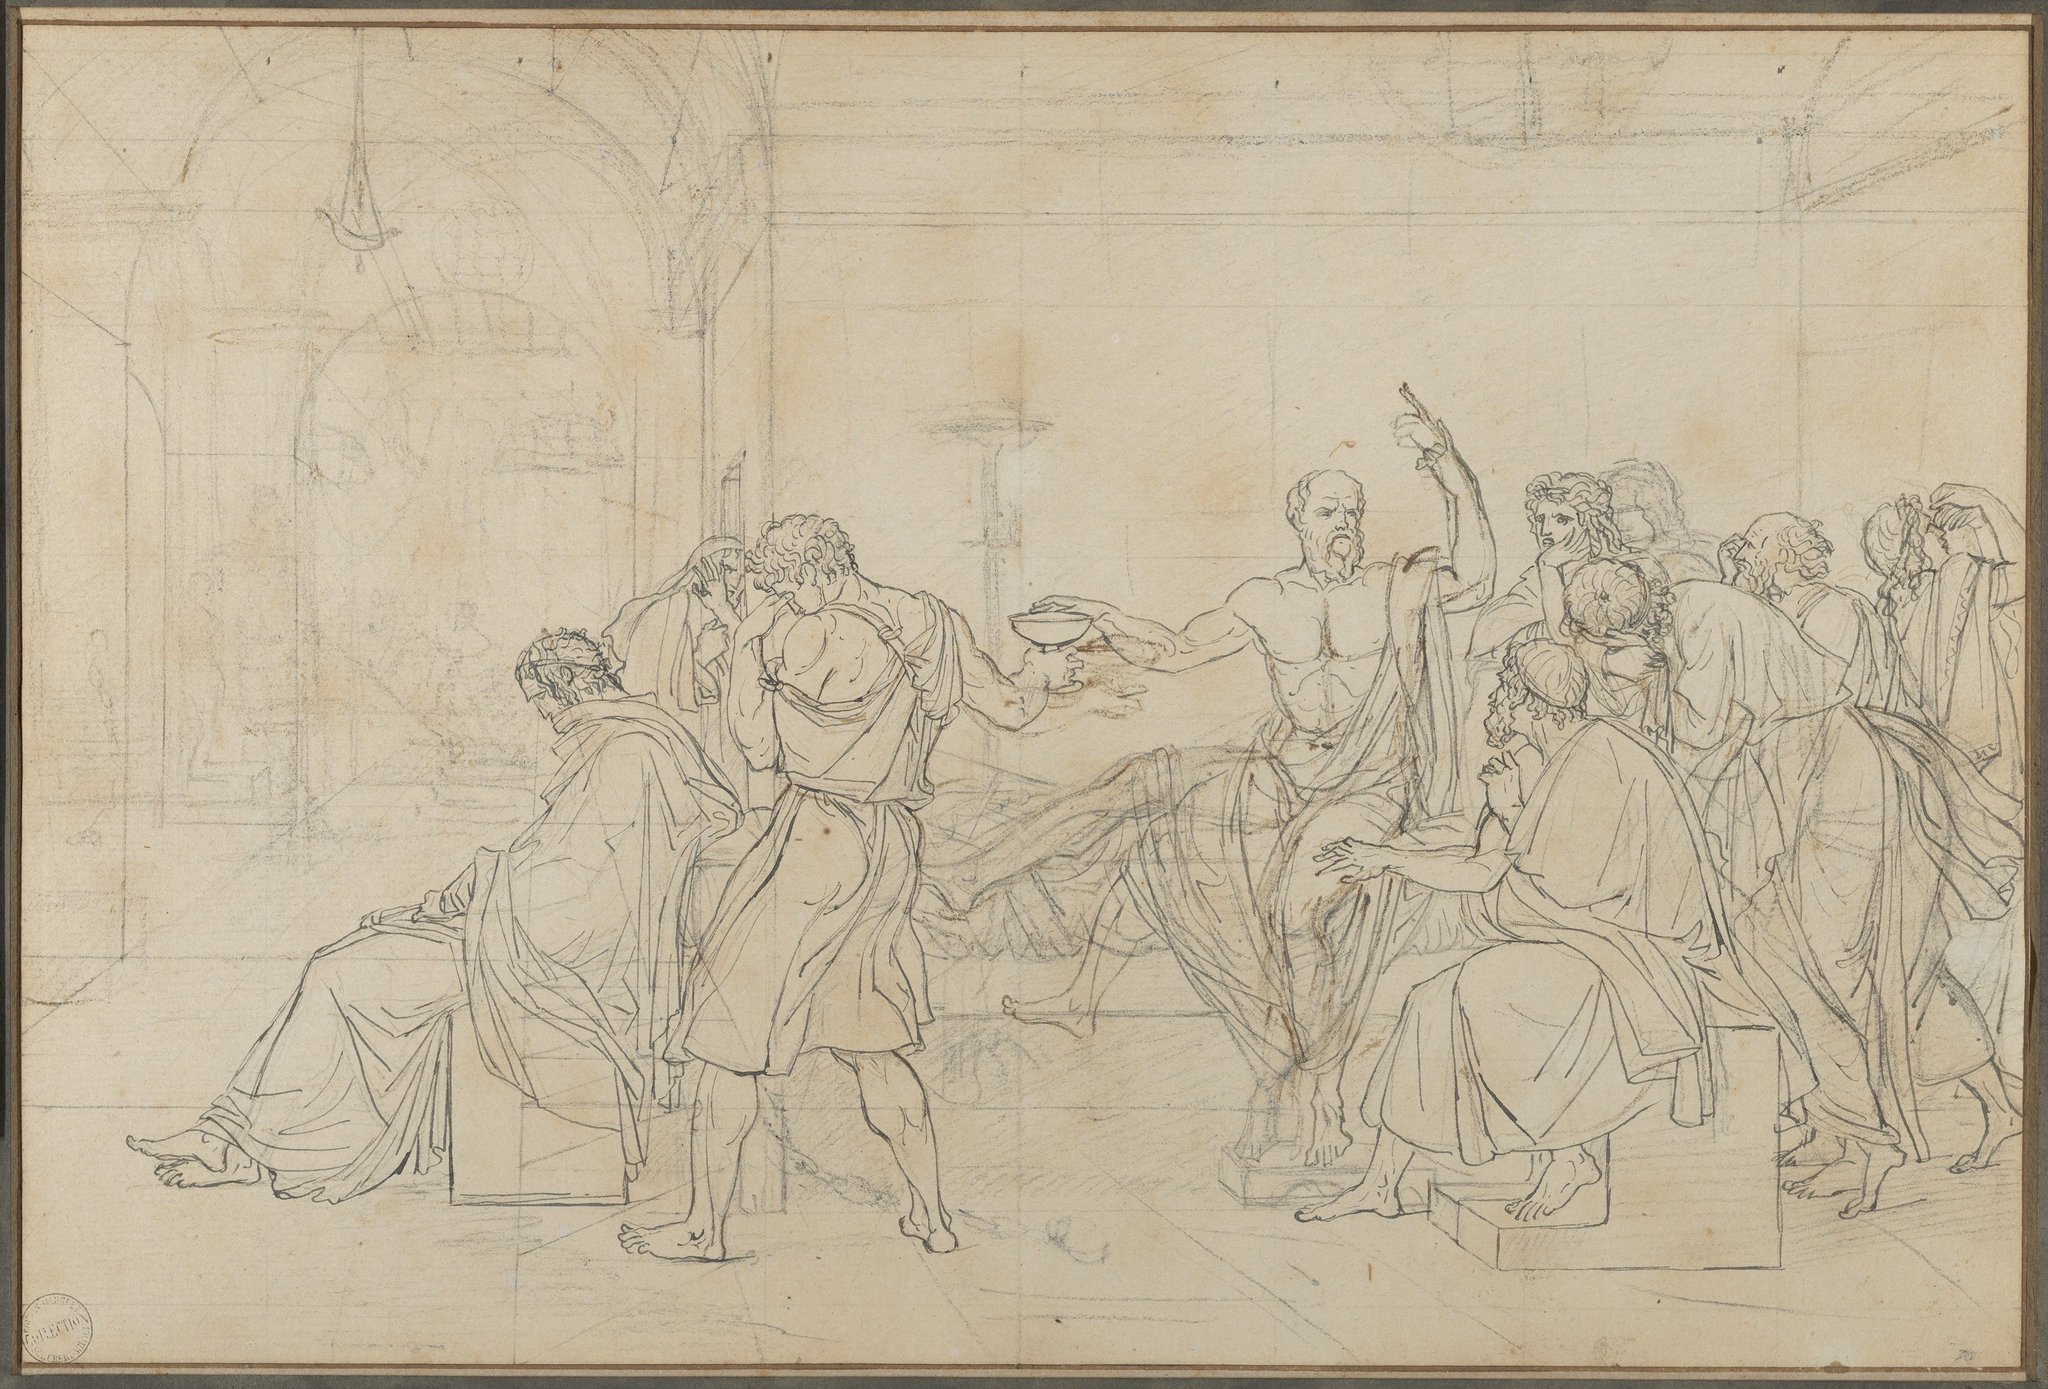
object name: drawing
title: The Death of Socrates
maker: jacques louis david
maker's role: artist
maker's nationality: french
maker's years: 1748-1825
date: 1786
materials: chalk, ink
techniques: pen, drawing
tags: socrates,men,death